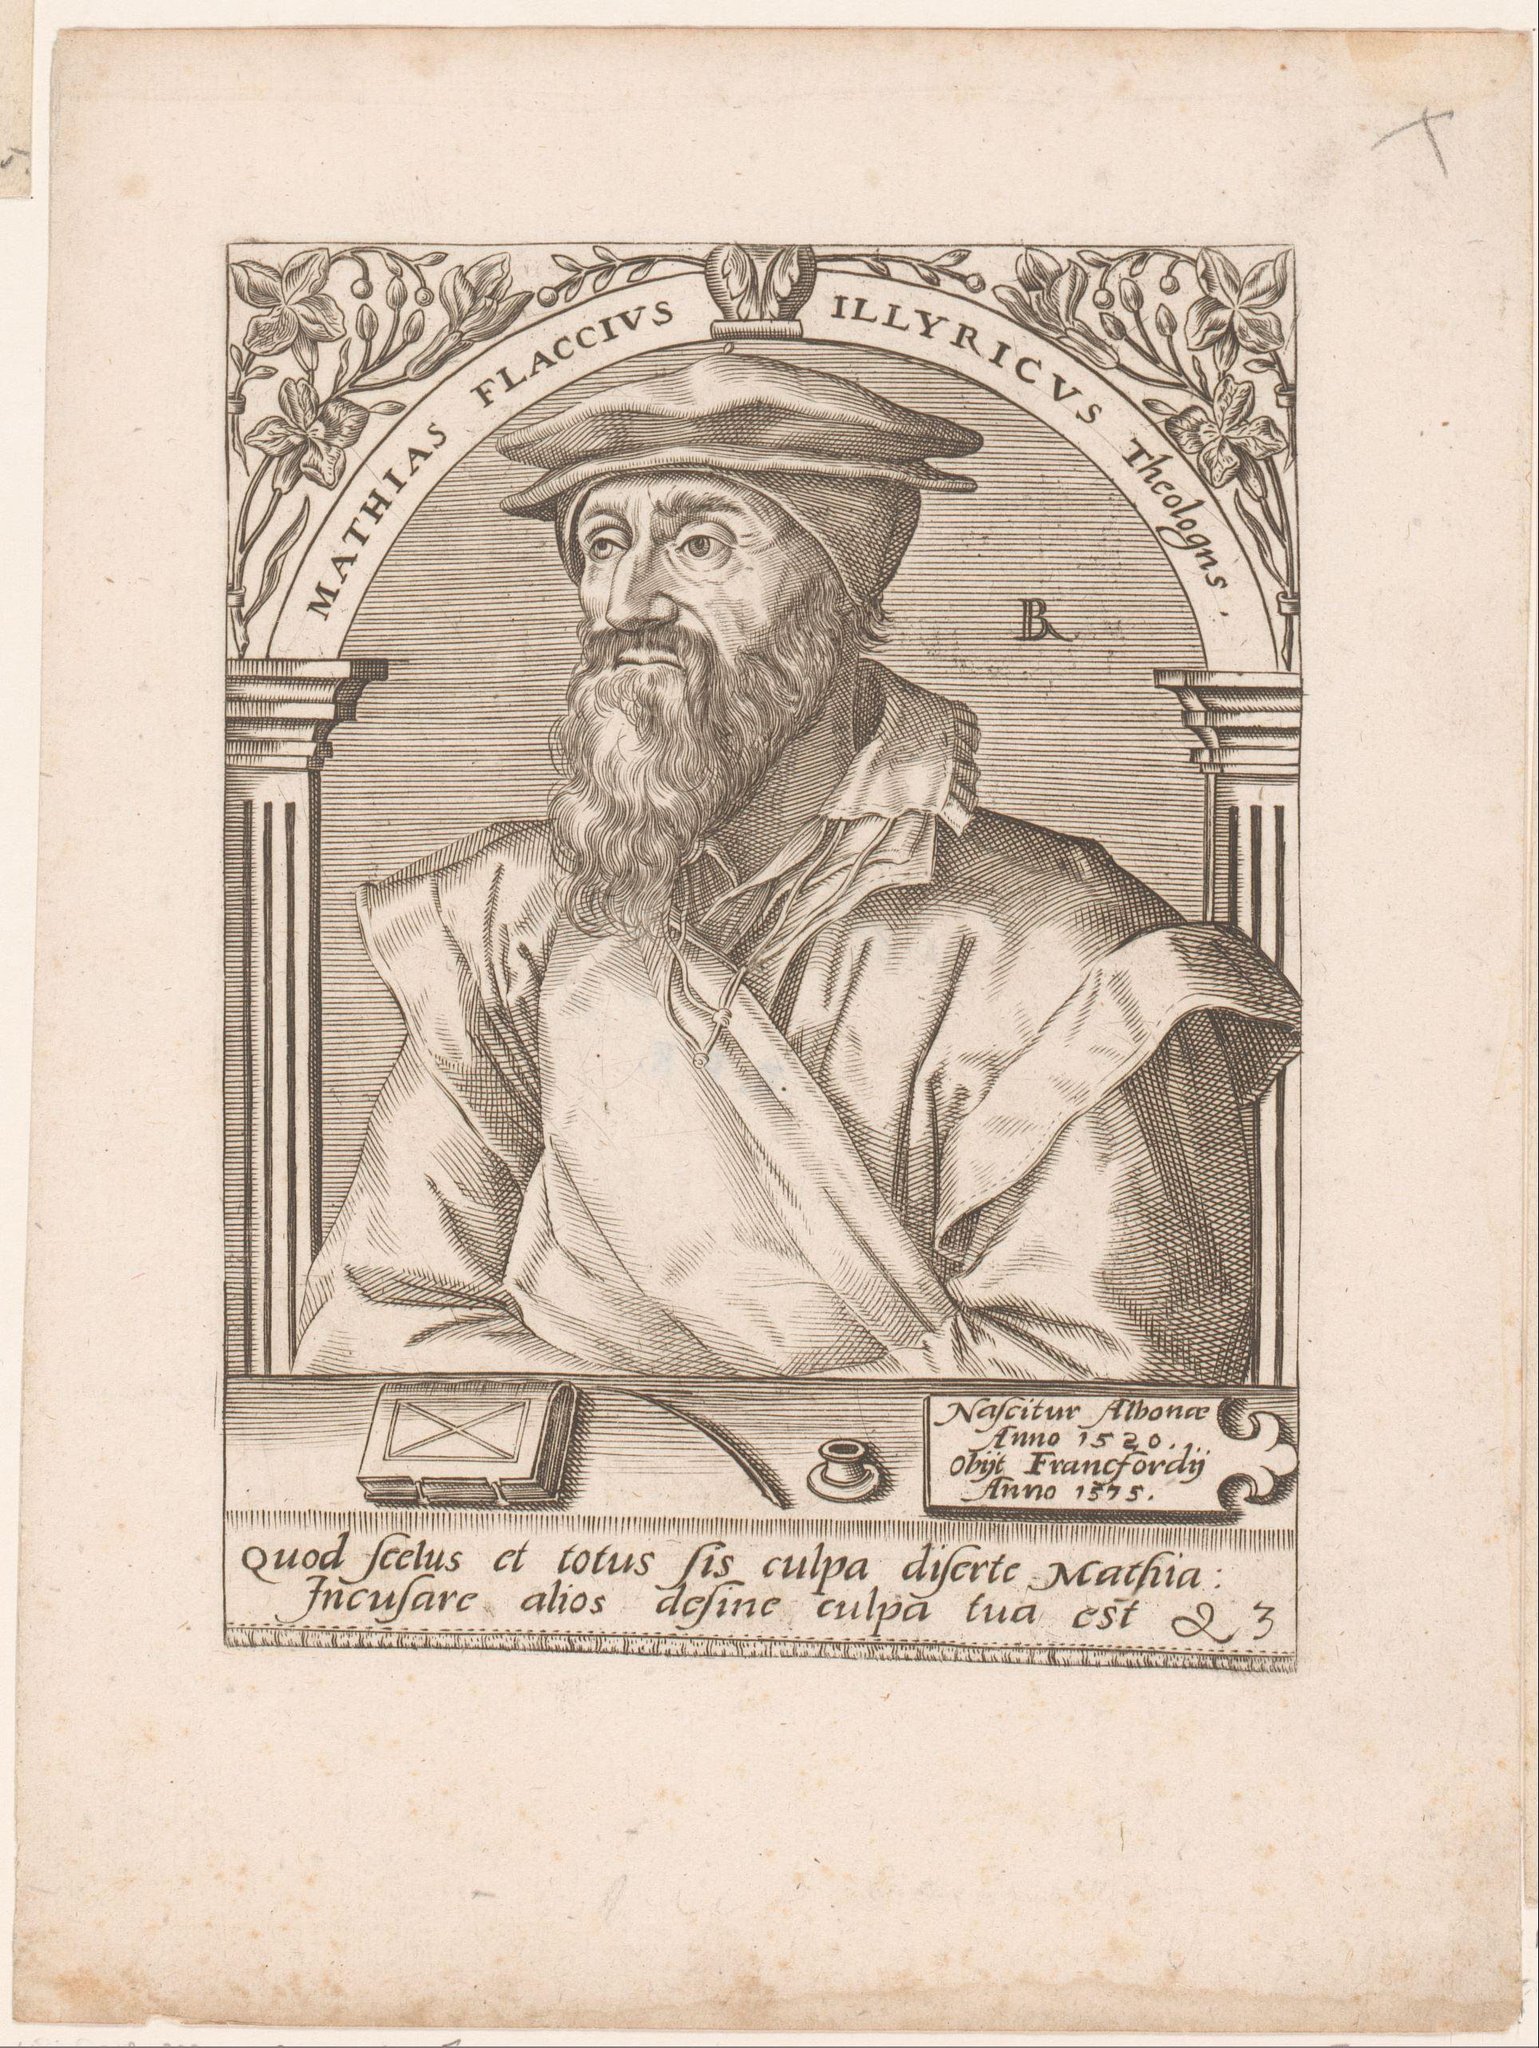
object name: print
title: Mathias Flaccius illyricus Theologns.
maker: robert boissard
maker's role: print maker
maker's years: 1570-1611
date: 1597-1599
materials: paper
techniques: engraving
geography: france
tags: historical persons, book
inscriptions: collector's mark: Lugt 2233